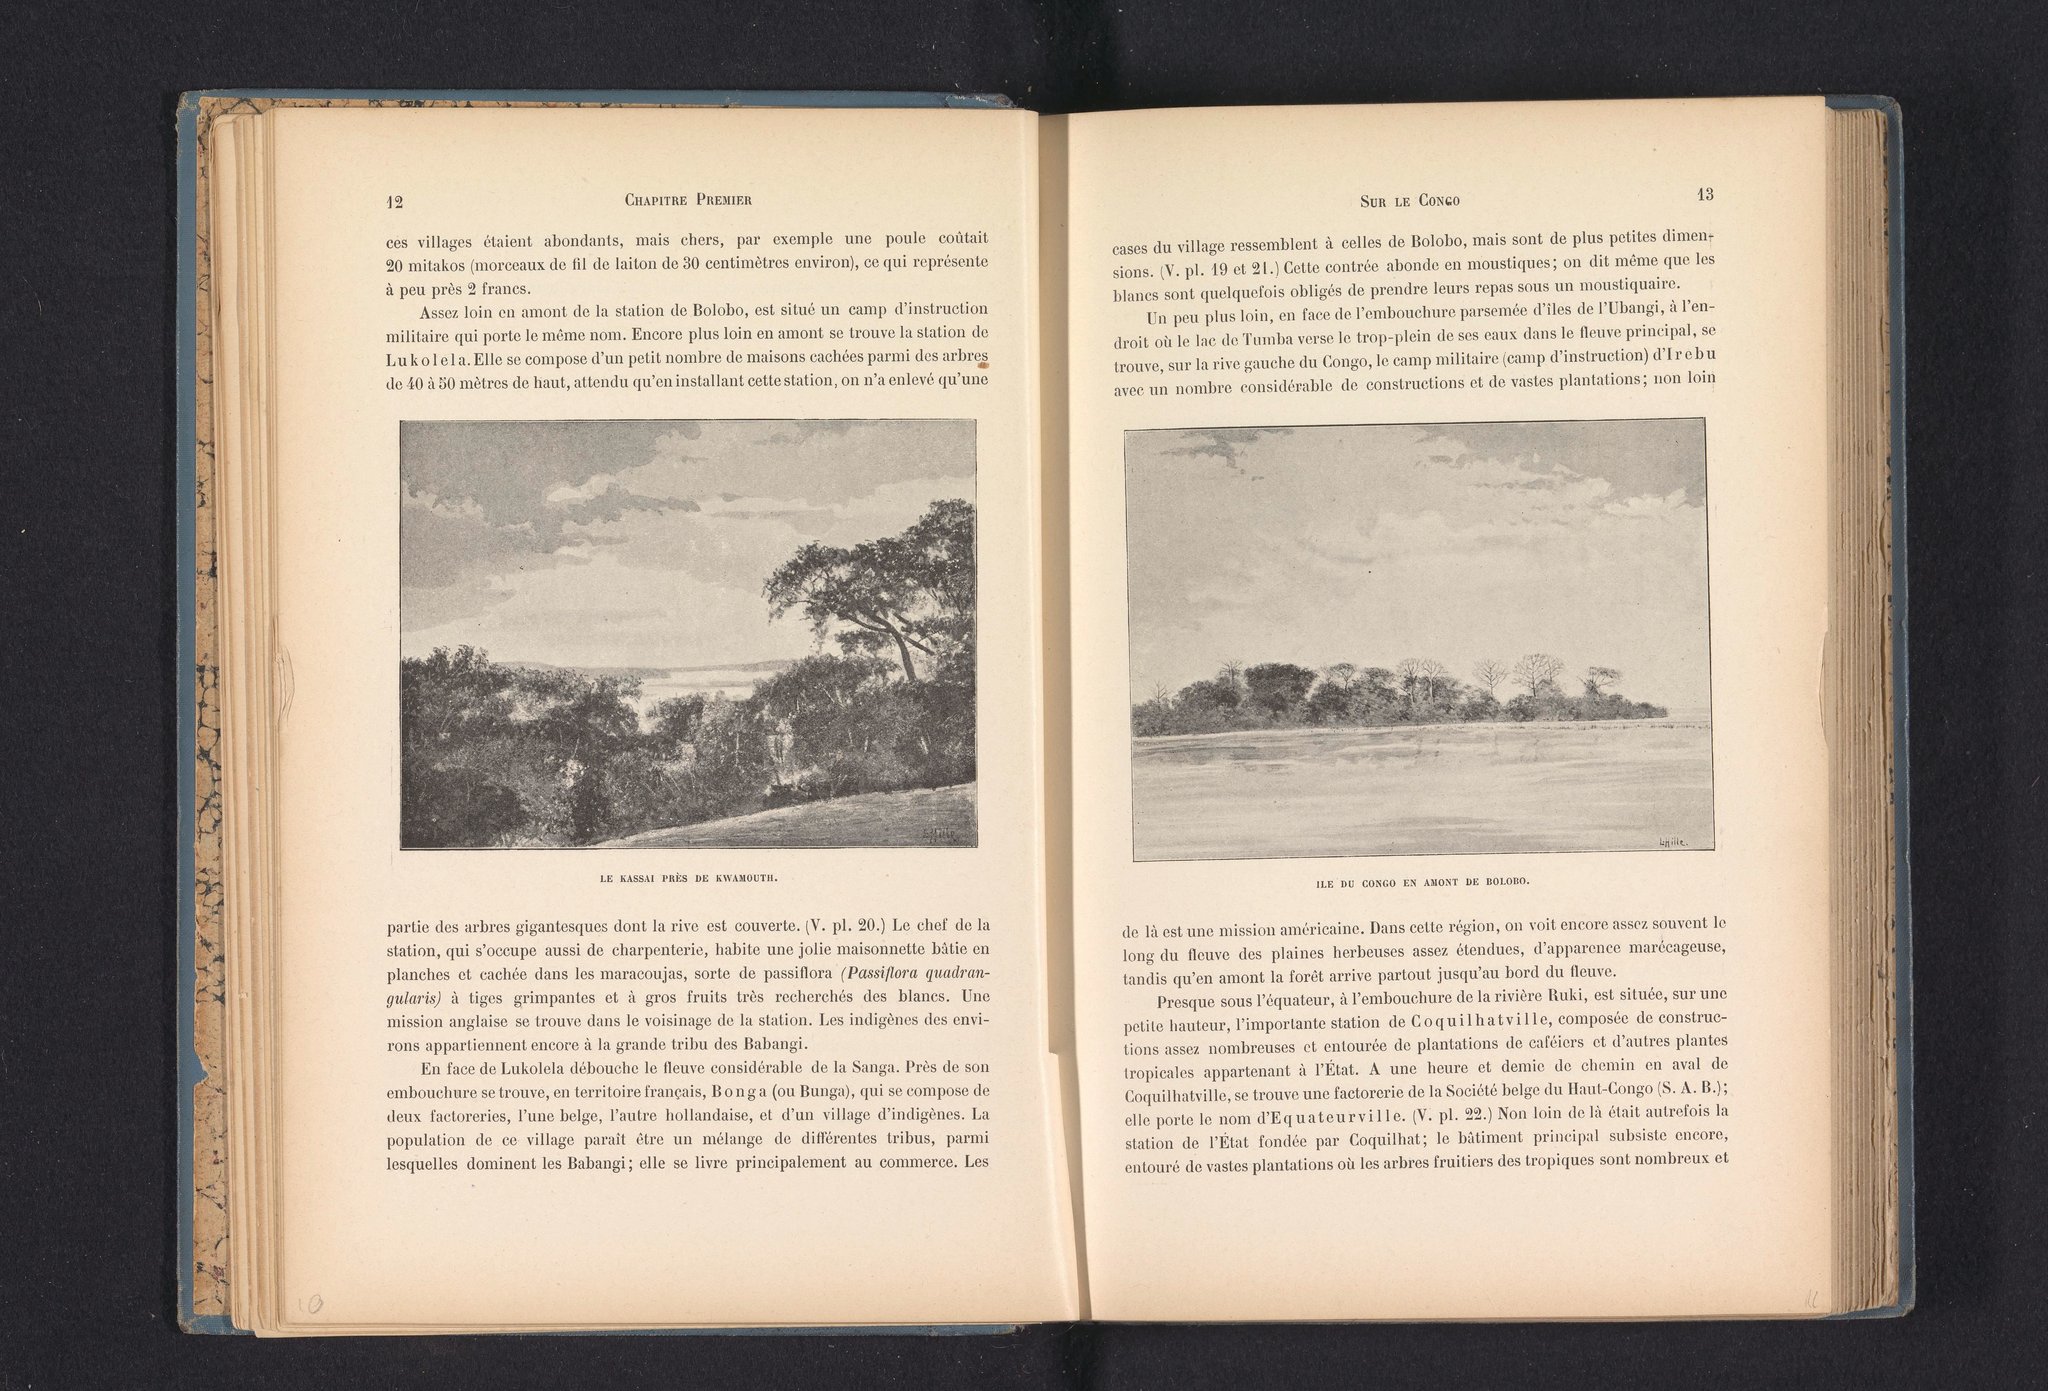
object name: page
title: Ile du Congo en amont de Bolobo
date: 1896-1899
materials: paper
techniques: autotype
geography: congo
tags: island